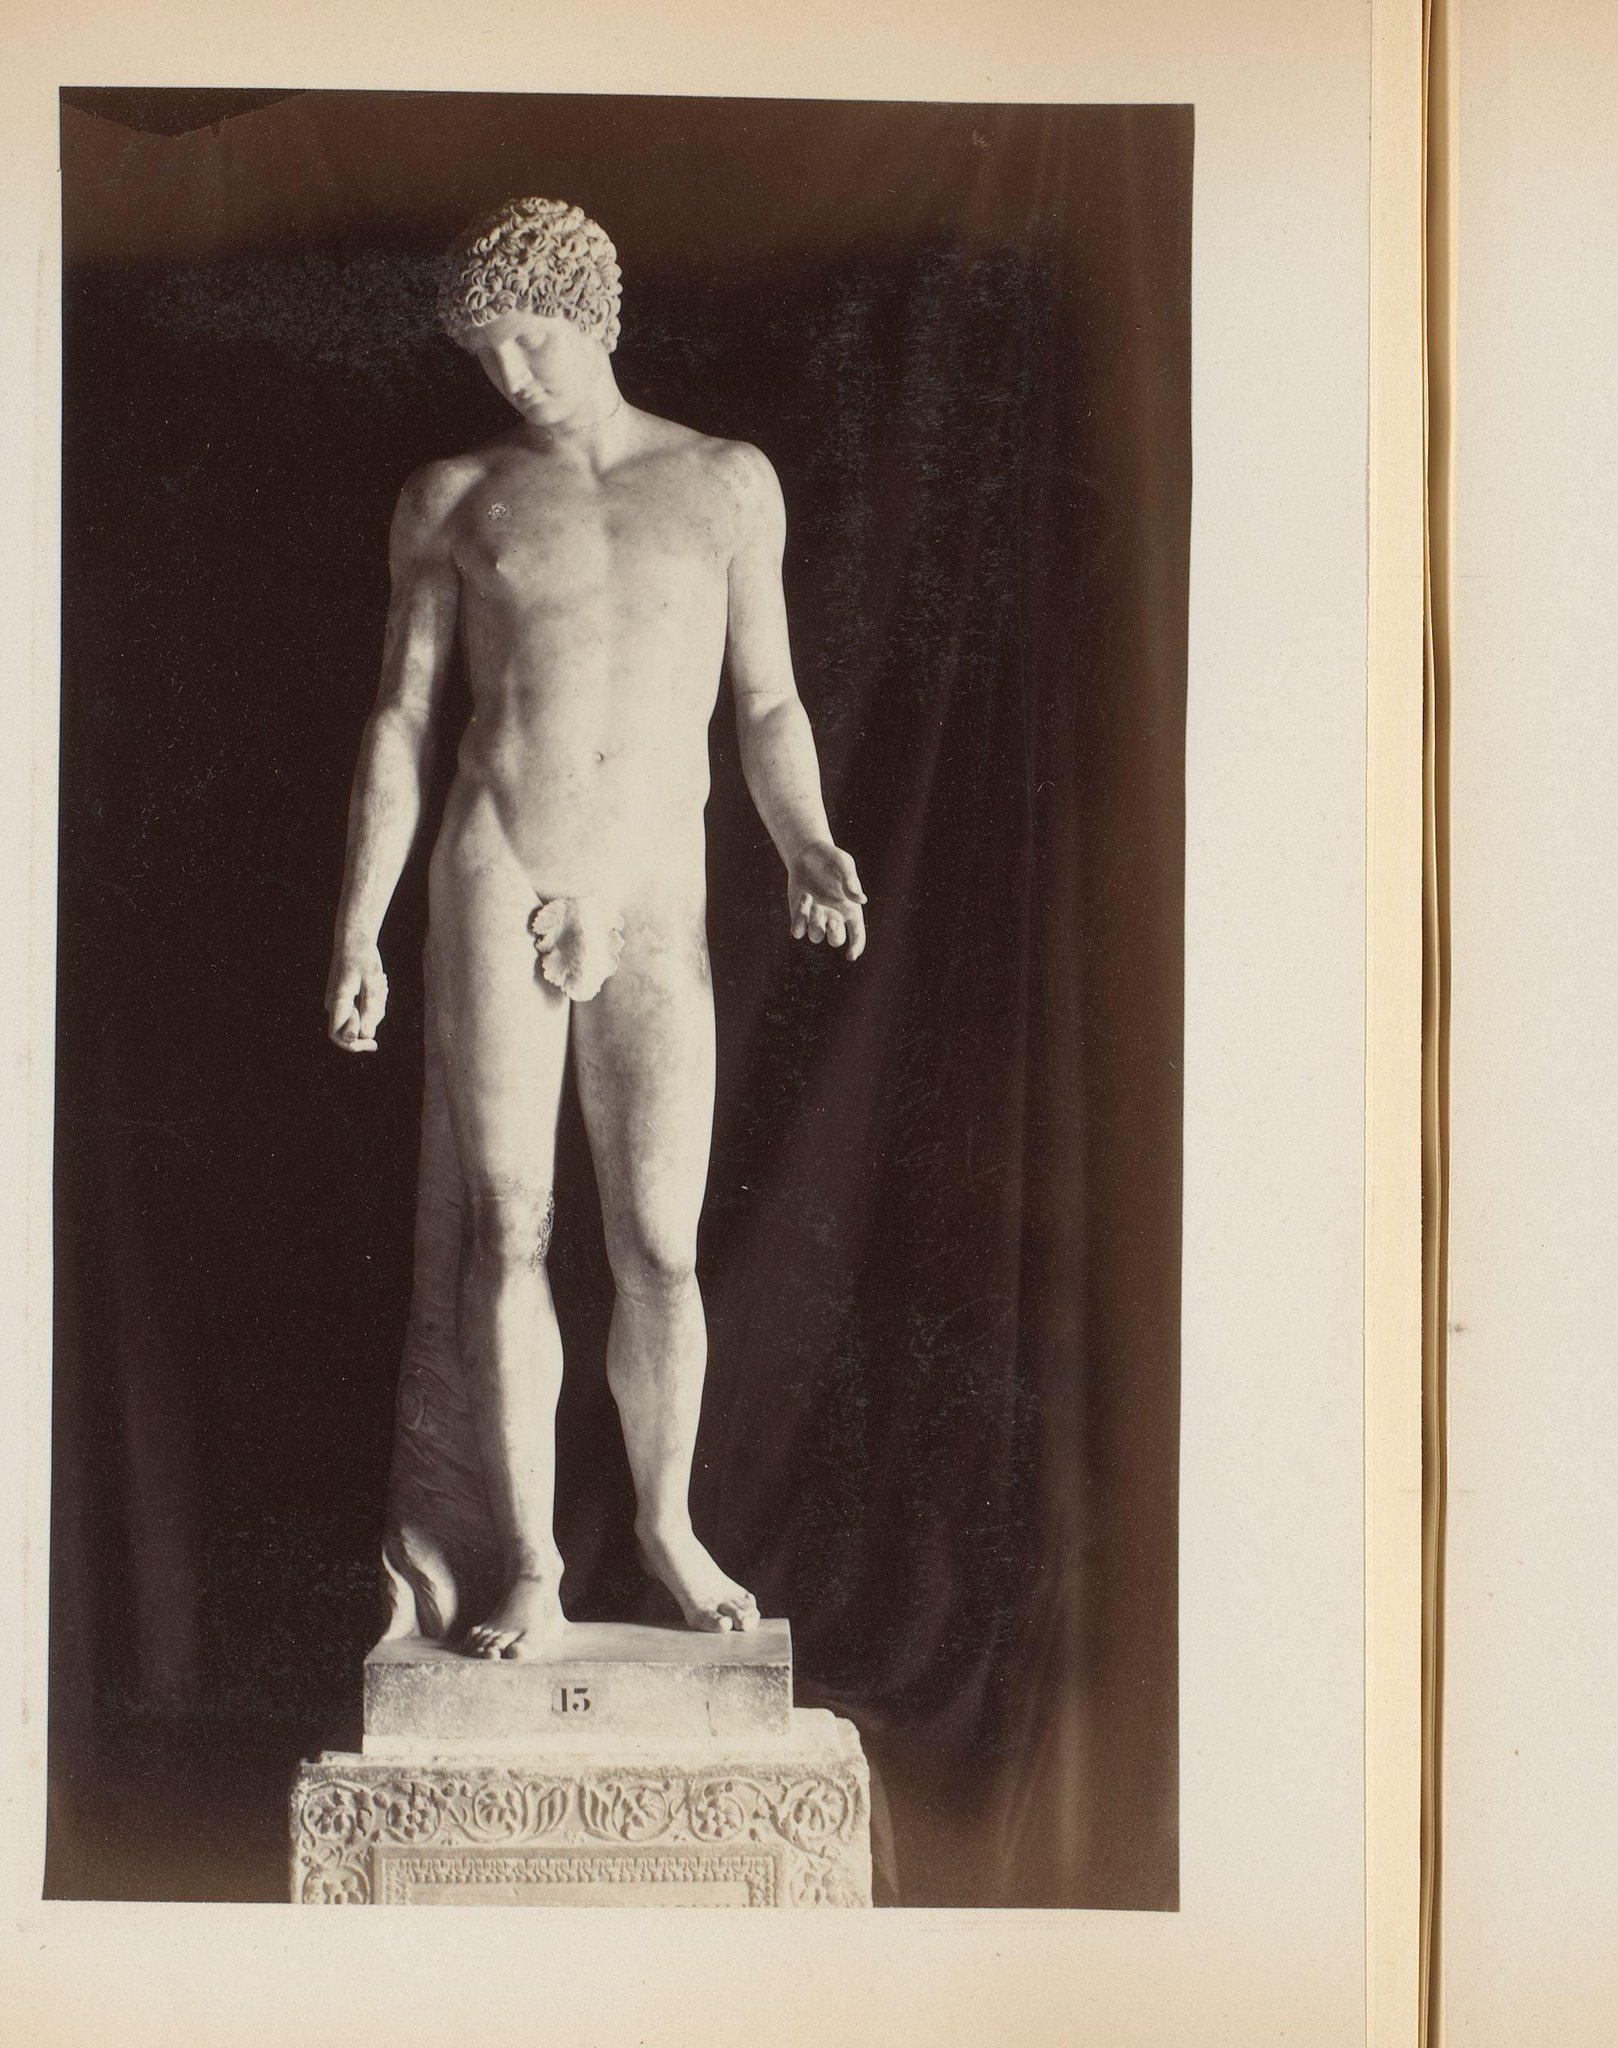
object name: photograph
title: Sculptuur van Antinoüs in de Capitolijnse Musea te Rome, Italië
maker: Anonymous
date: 1870-1890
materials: paper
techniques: albumen print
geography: rome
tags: piece of sculpture, reproduction of a piece of sculpture